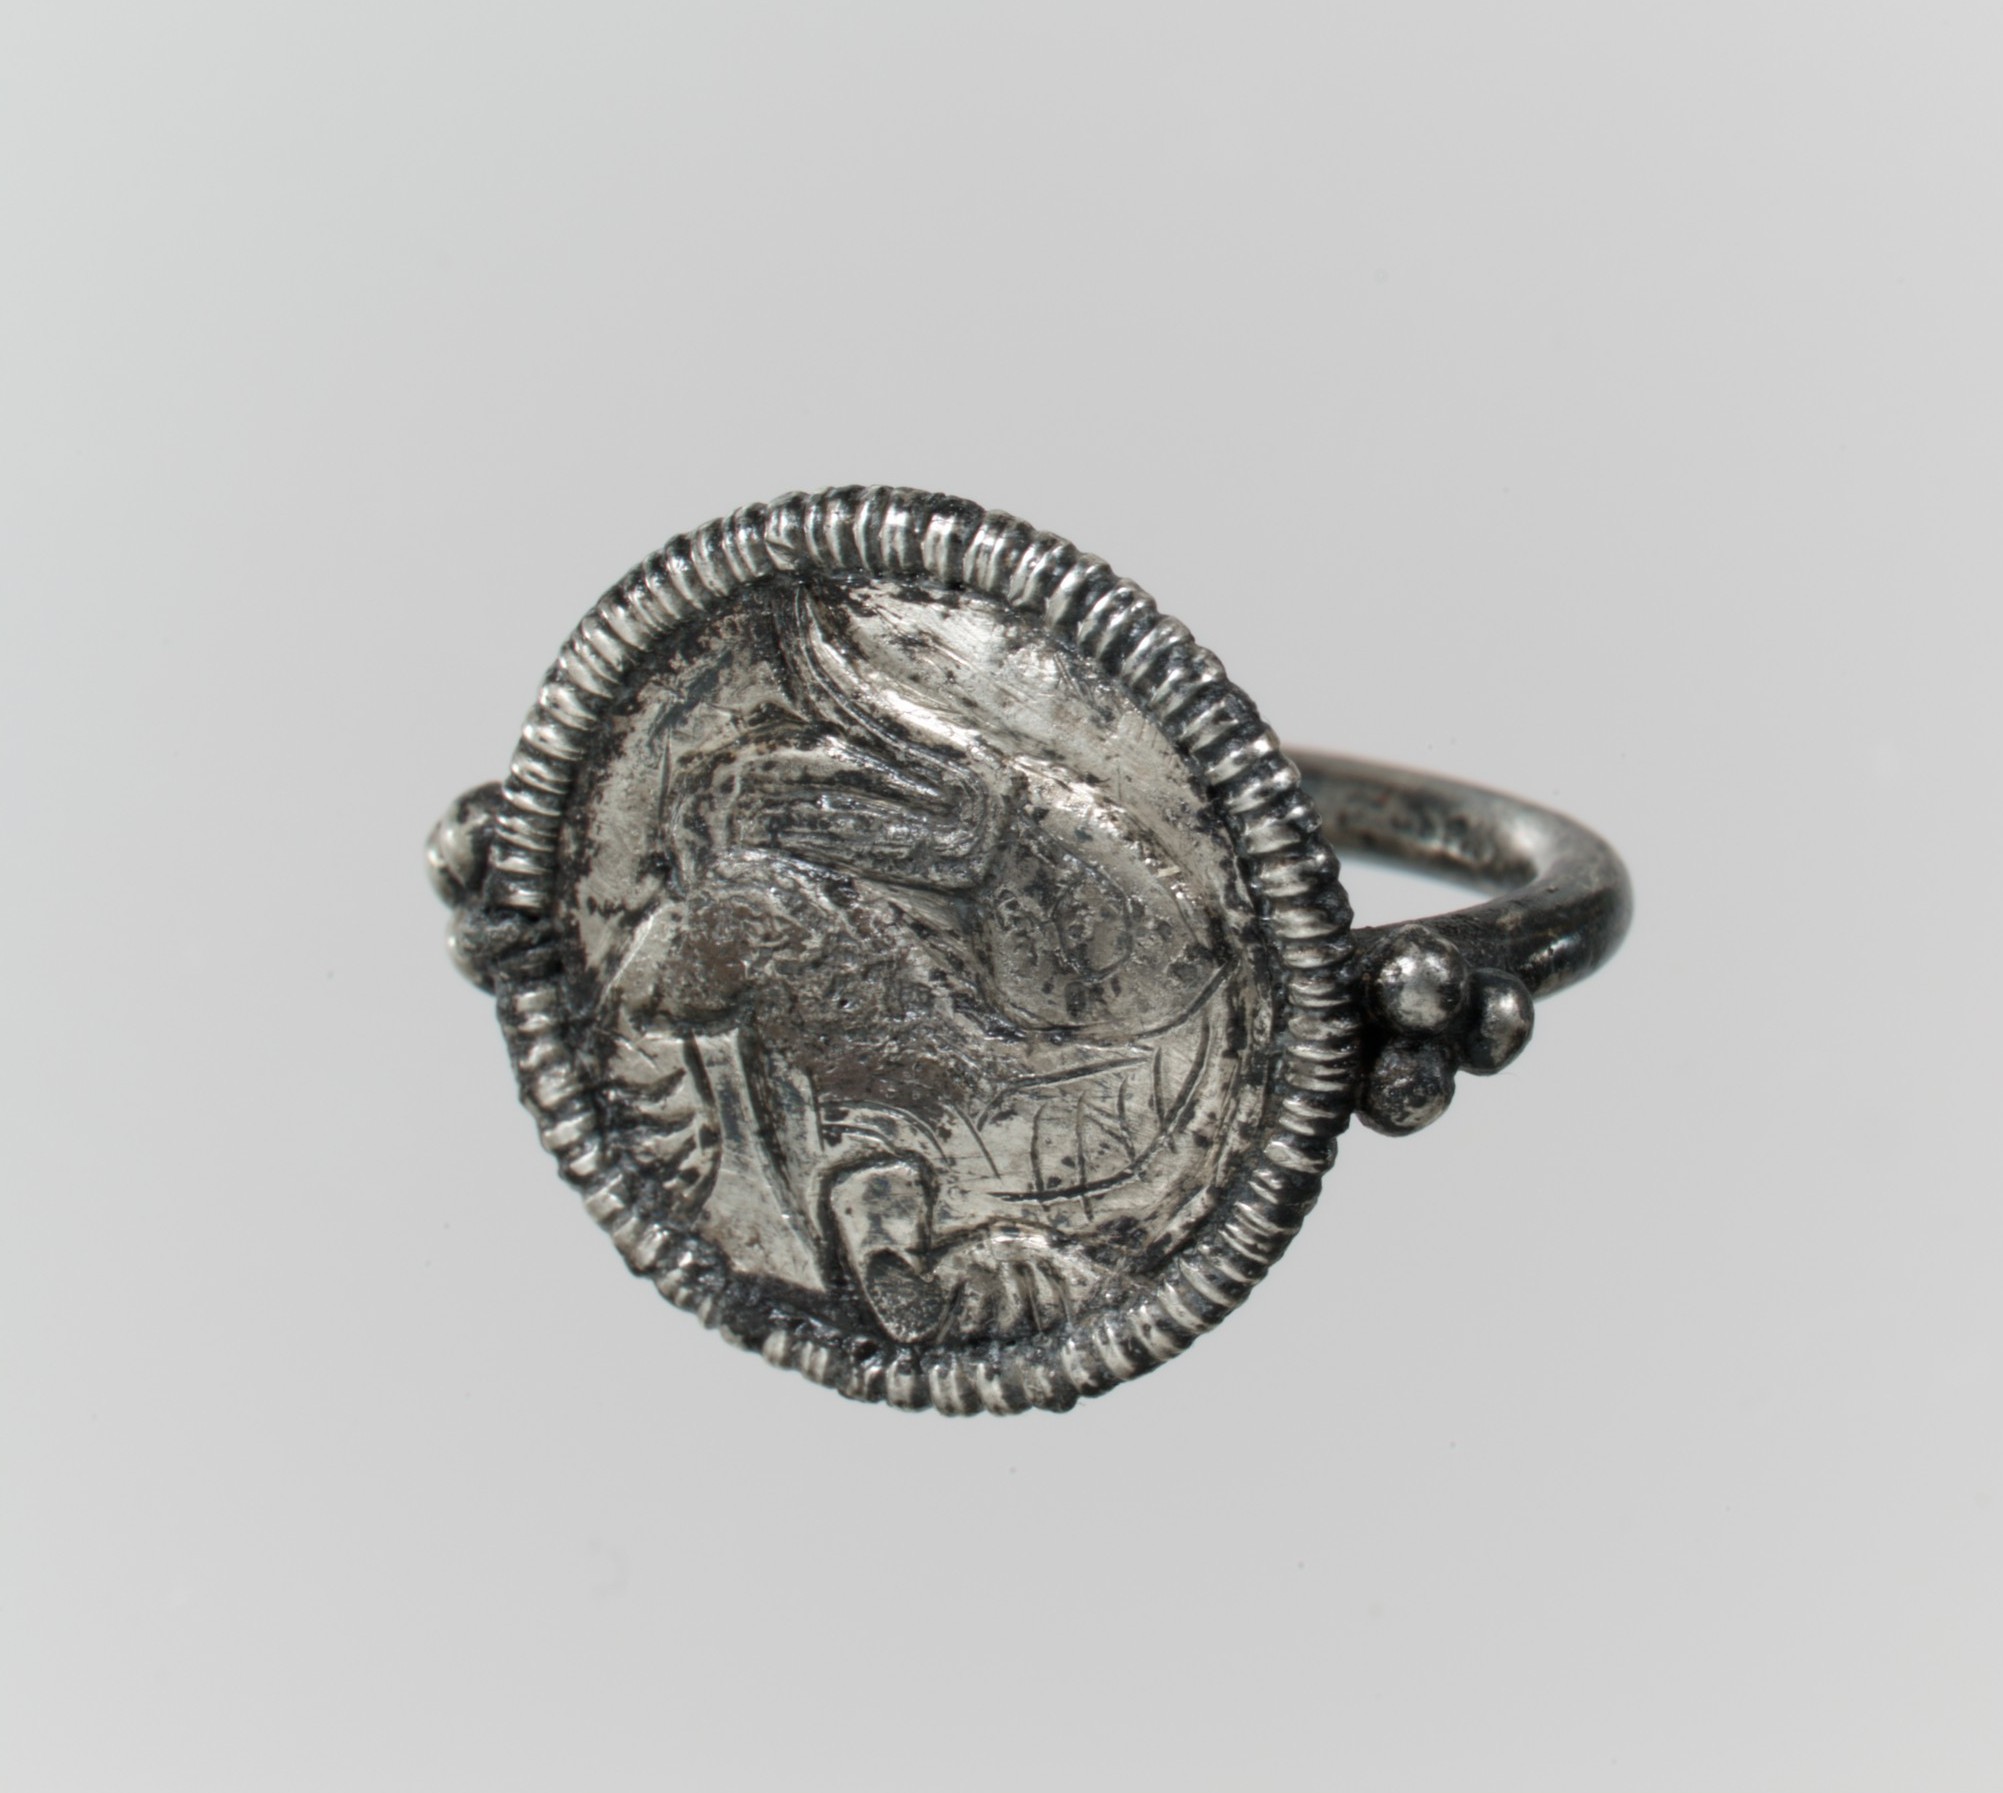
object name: ring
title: Finger Ring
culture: frankish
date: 501-633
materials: silver